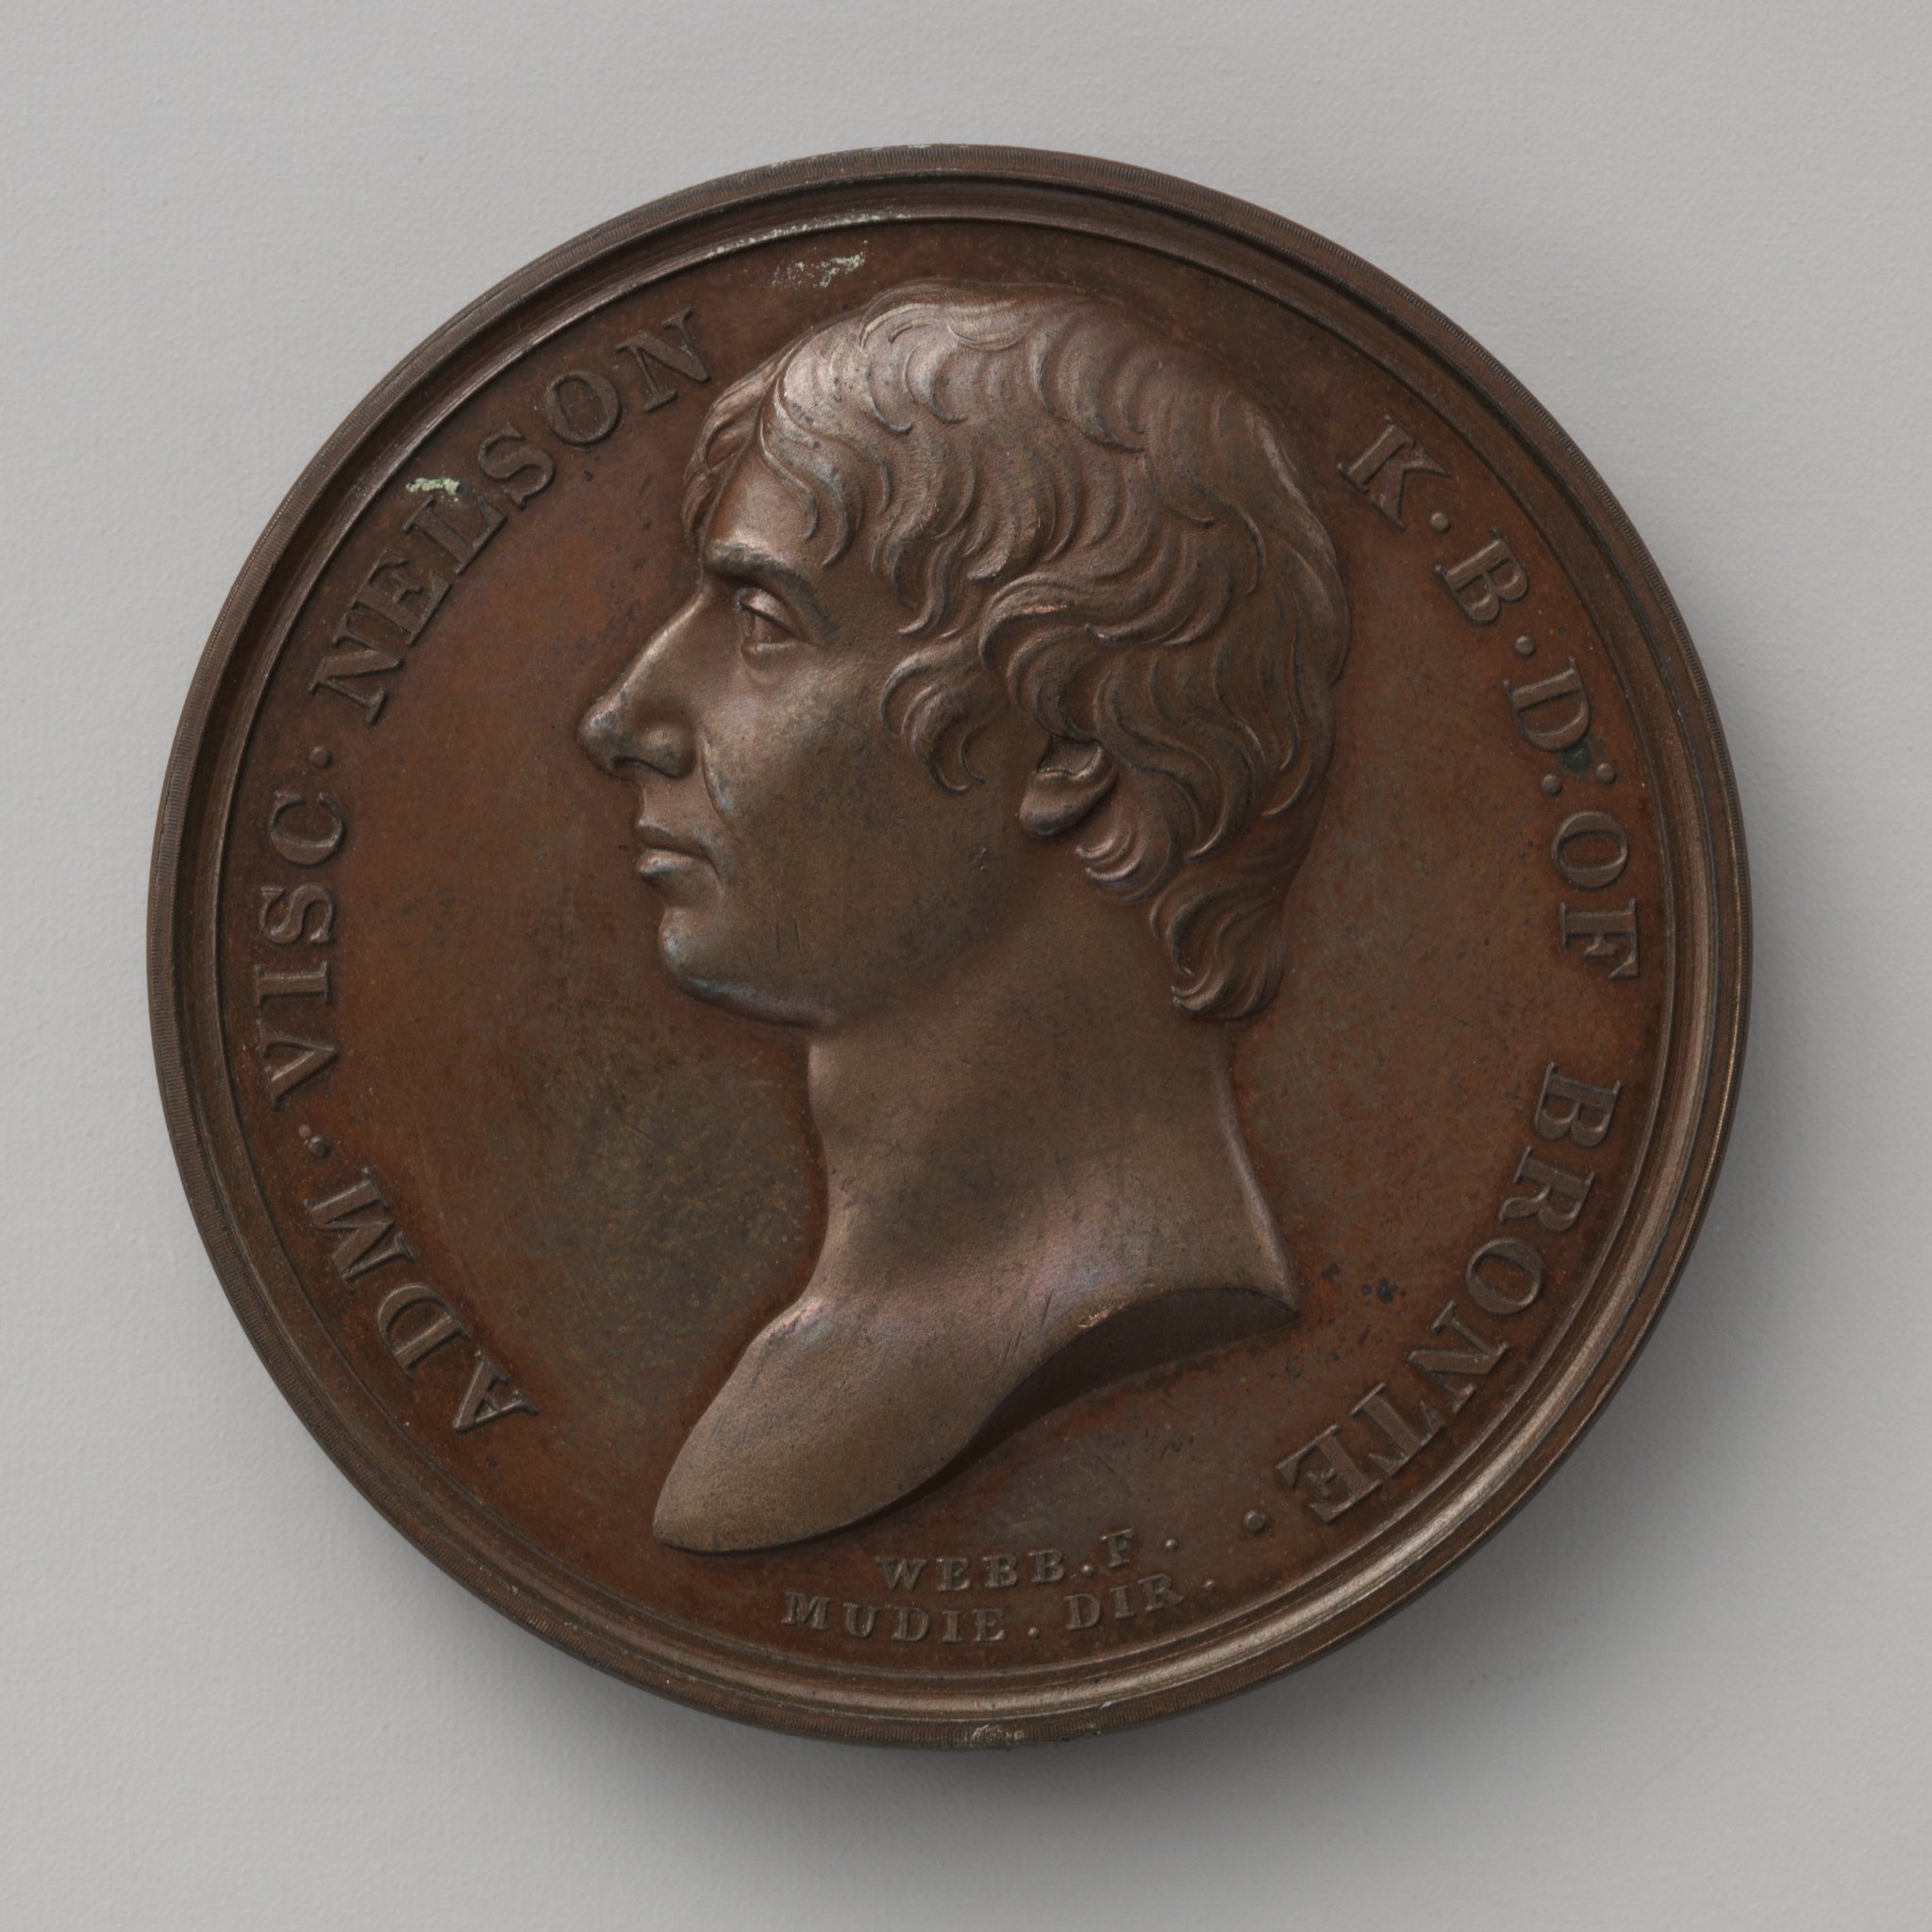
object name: medal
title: In Memory of Lord Nelson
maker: jean-pierre droz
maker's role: artist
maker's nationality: french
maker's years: 1746-1823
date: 1805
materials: bronze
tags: men,profiles,women